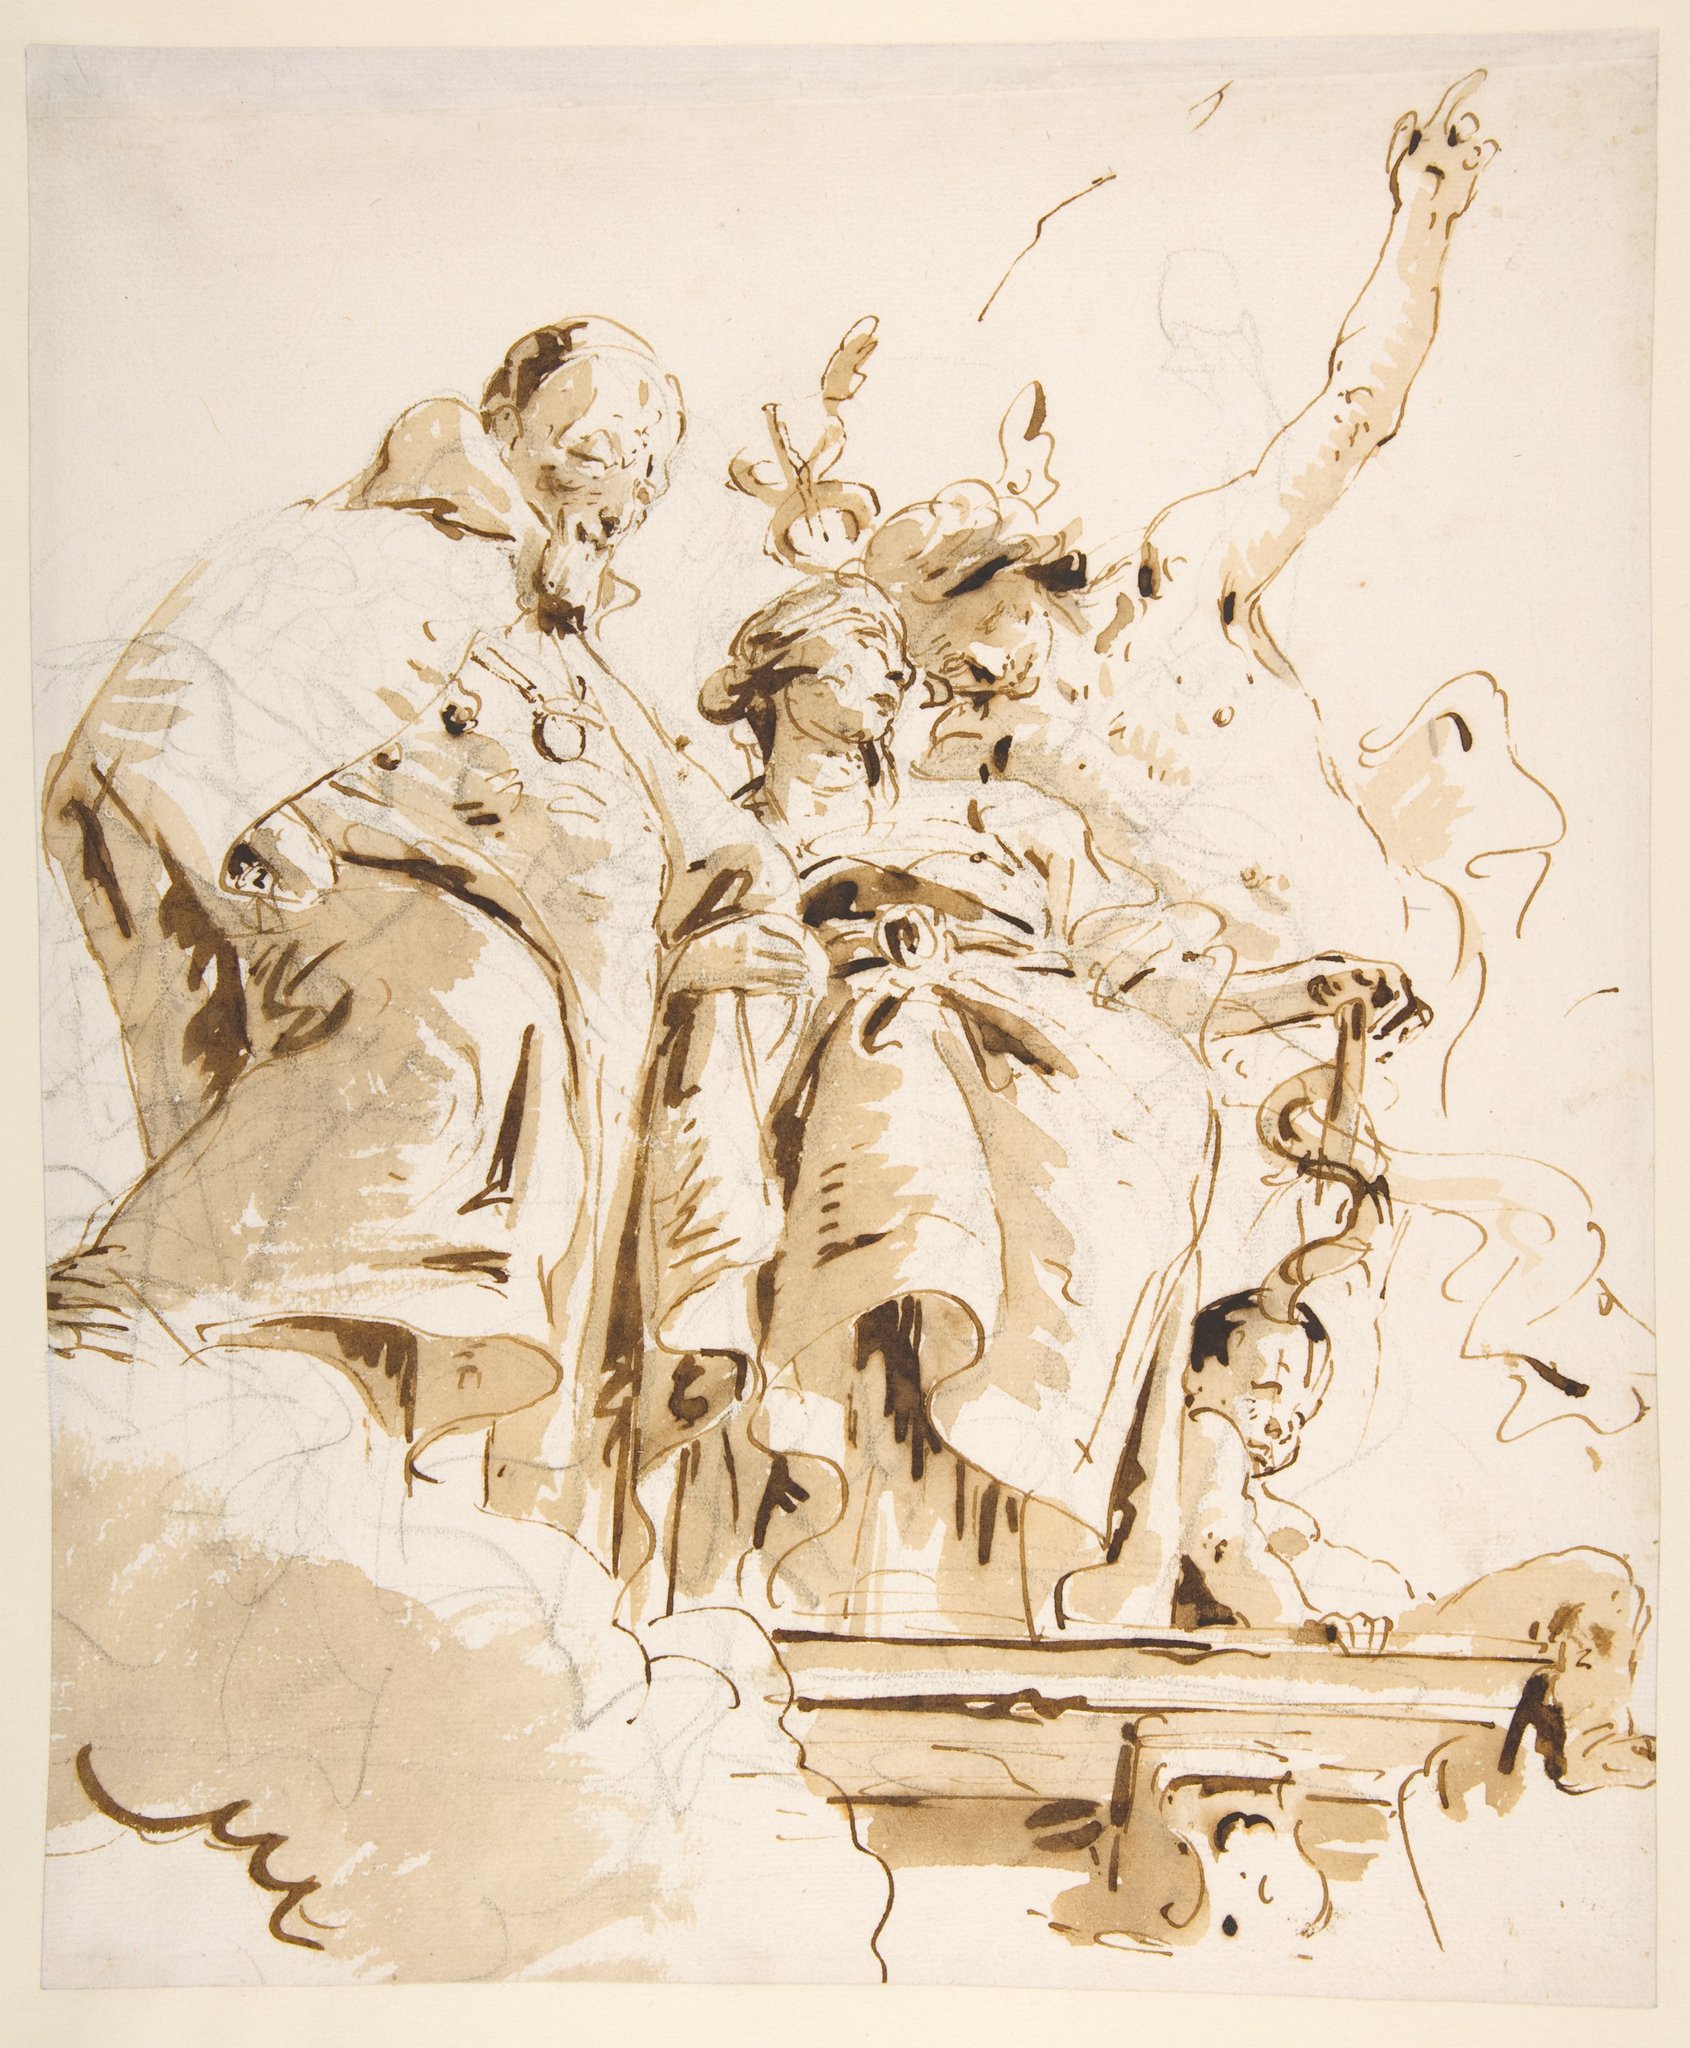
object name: drawing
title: Aged Dignitary Attended by Mercury and Prudence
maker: giovanni battista tiepolo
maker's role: artist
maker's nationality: italian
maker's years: 1696-1770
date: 1696-1770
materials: chalk, ink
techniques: brush, pen, wash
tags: men,women,mercury